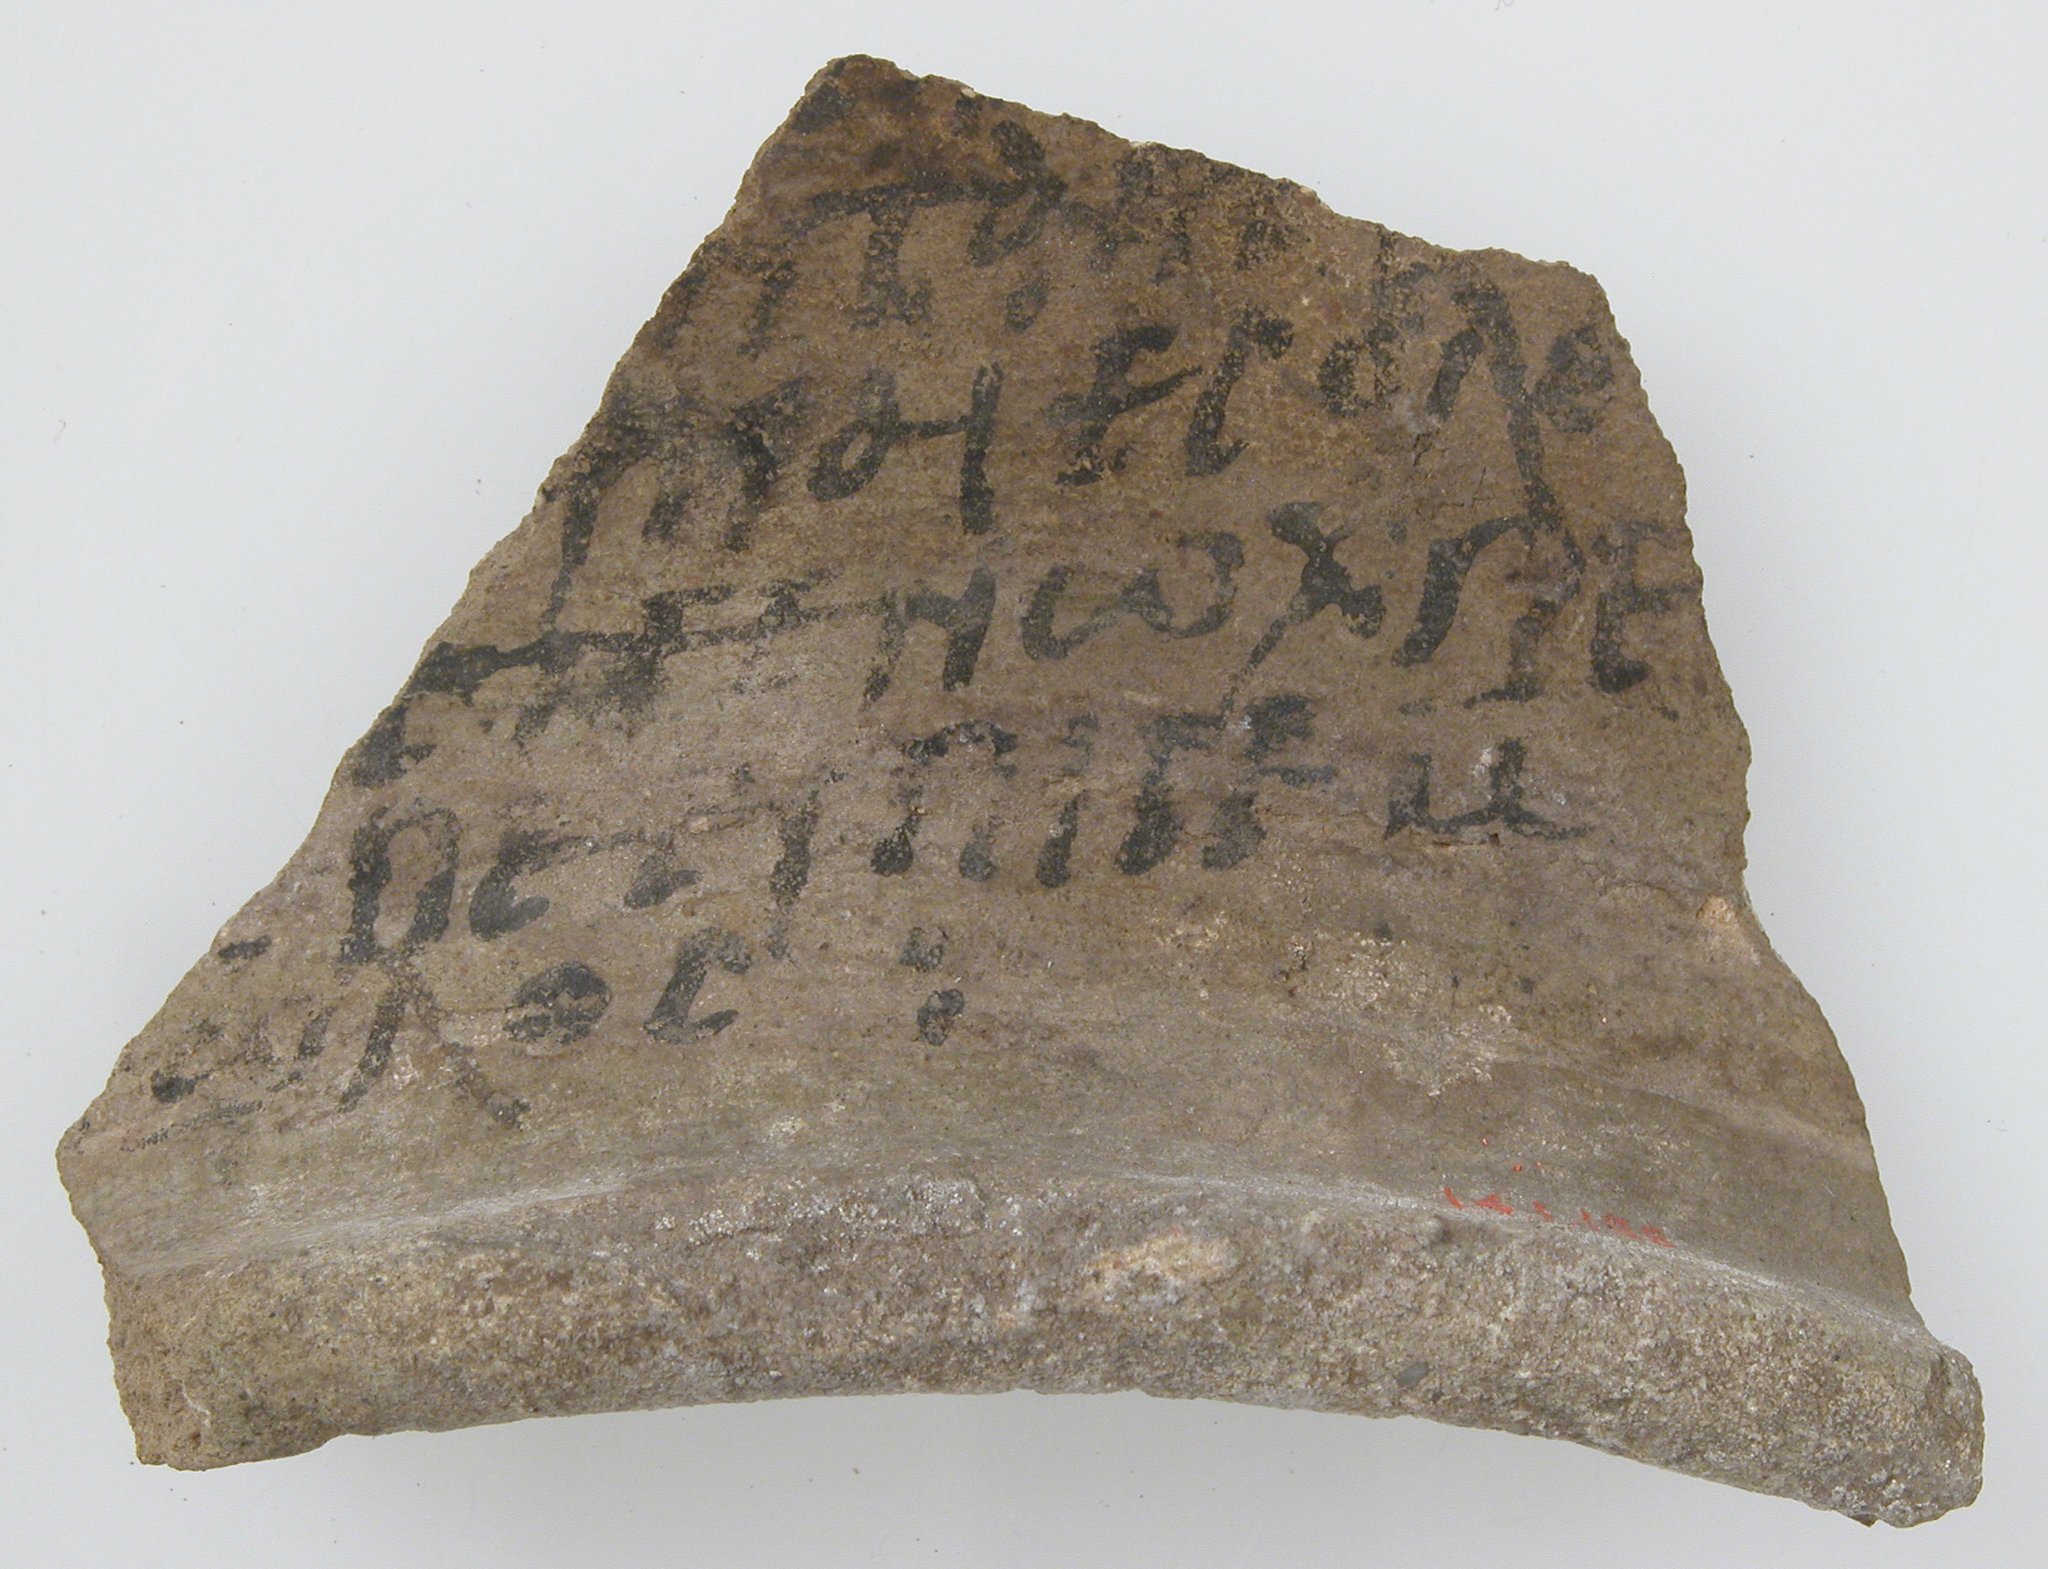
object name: ostrakon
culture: coptic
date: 580-640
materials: ink, pottery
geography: egypt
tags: coptic,documents